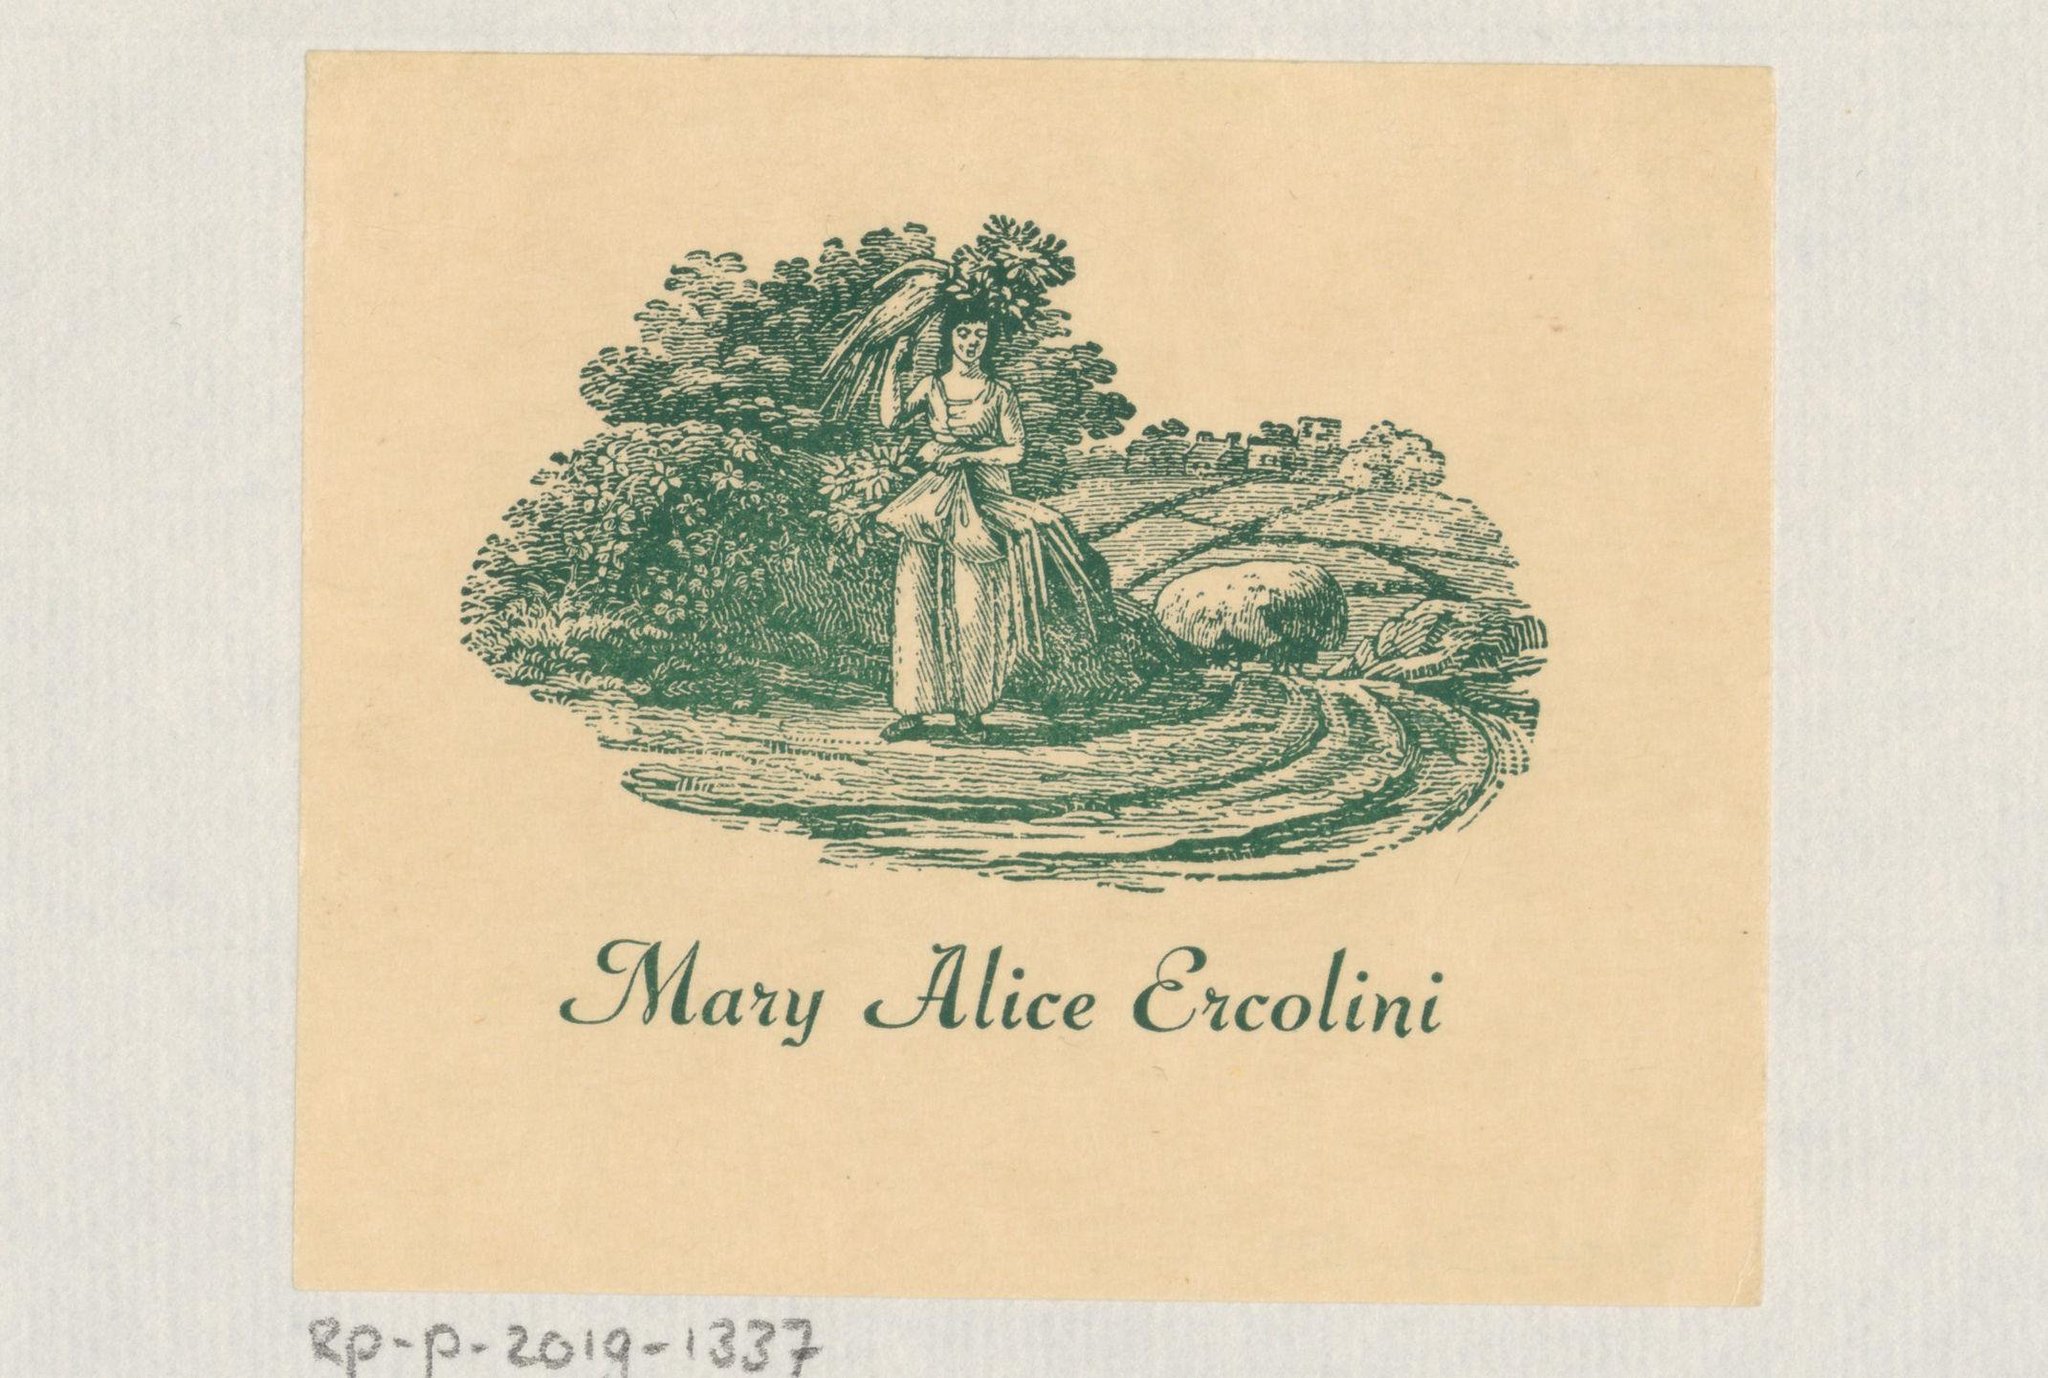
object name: bookplate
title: Ex libris van Mary Alice Ercolini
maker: thomas bewick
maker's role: draughtsman, painter, print maker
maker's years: 1753-1828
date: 1790-1826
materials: paper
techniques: engraving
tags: mary alice ercolini, predatory birds: falcon, dale, valley